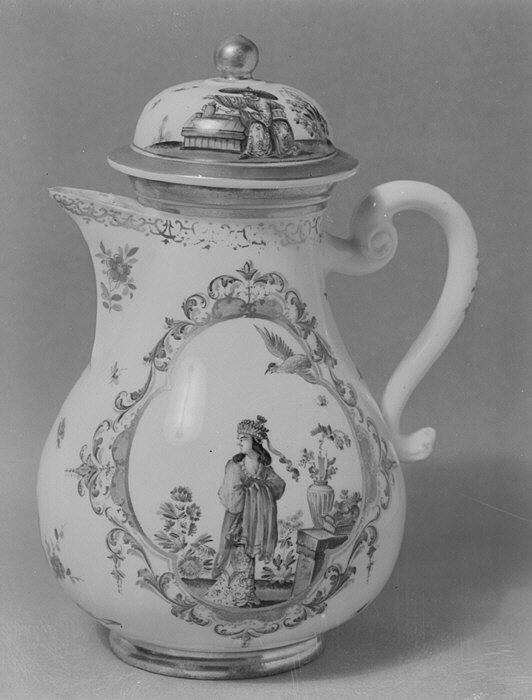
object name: coffeepot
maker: meissen manufactory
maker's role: manufactory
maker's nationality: german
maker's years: 1710-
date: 1725-1730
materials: hard paste porcelain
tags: human figures,birds